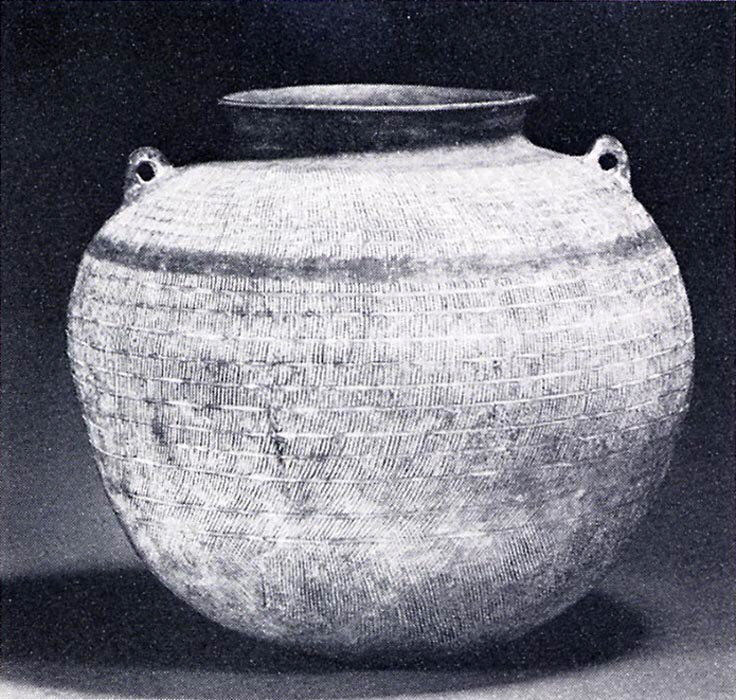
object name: jar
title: Jar with small loop handles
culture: korean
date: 201-400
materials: earthenware